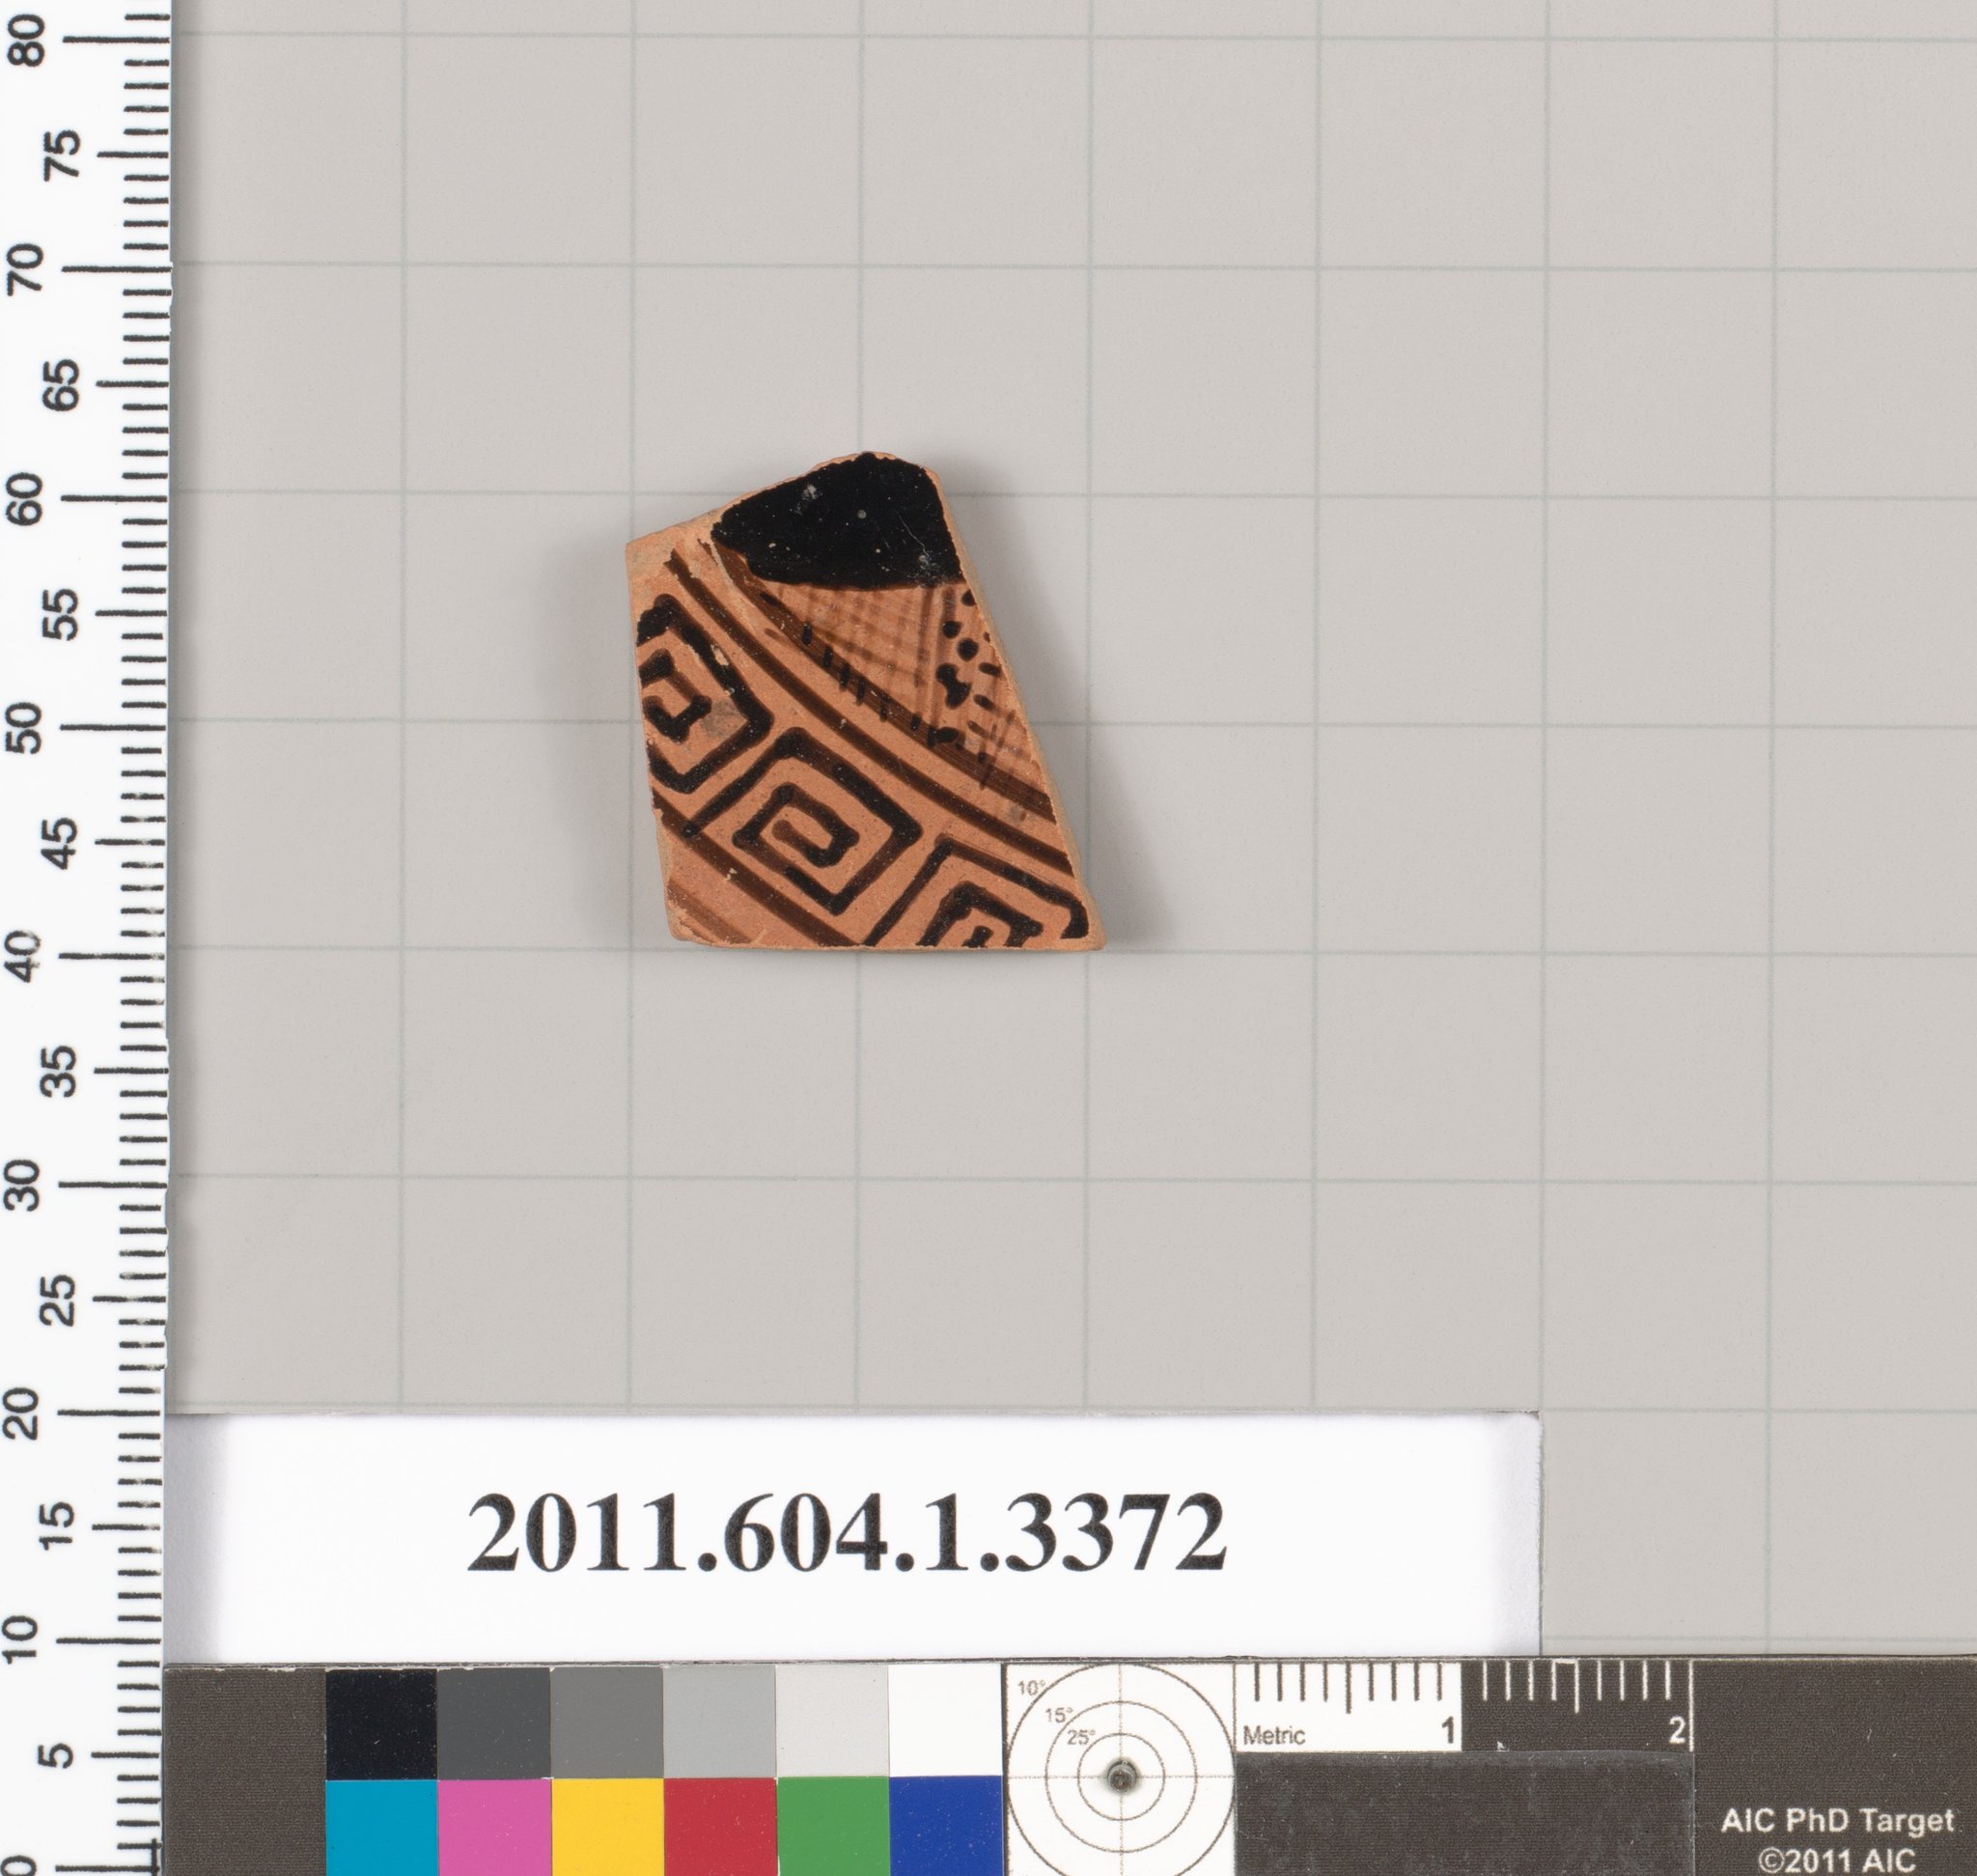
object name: kylix fragment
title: Terracotta fragment of a kylix (drinking cup)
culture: greek, attic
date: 475-451 BCE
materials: terracotta